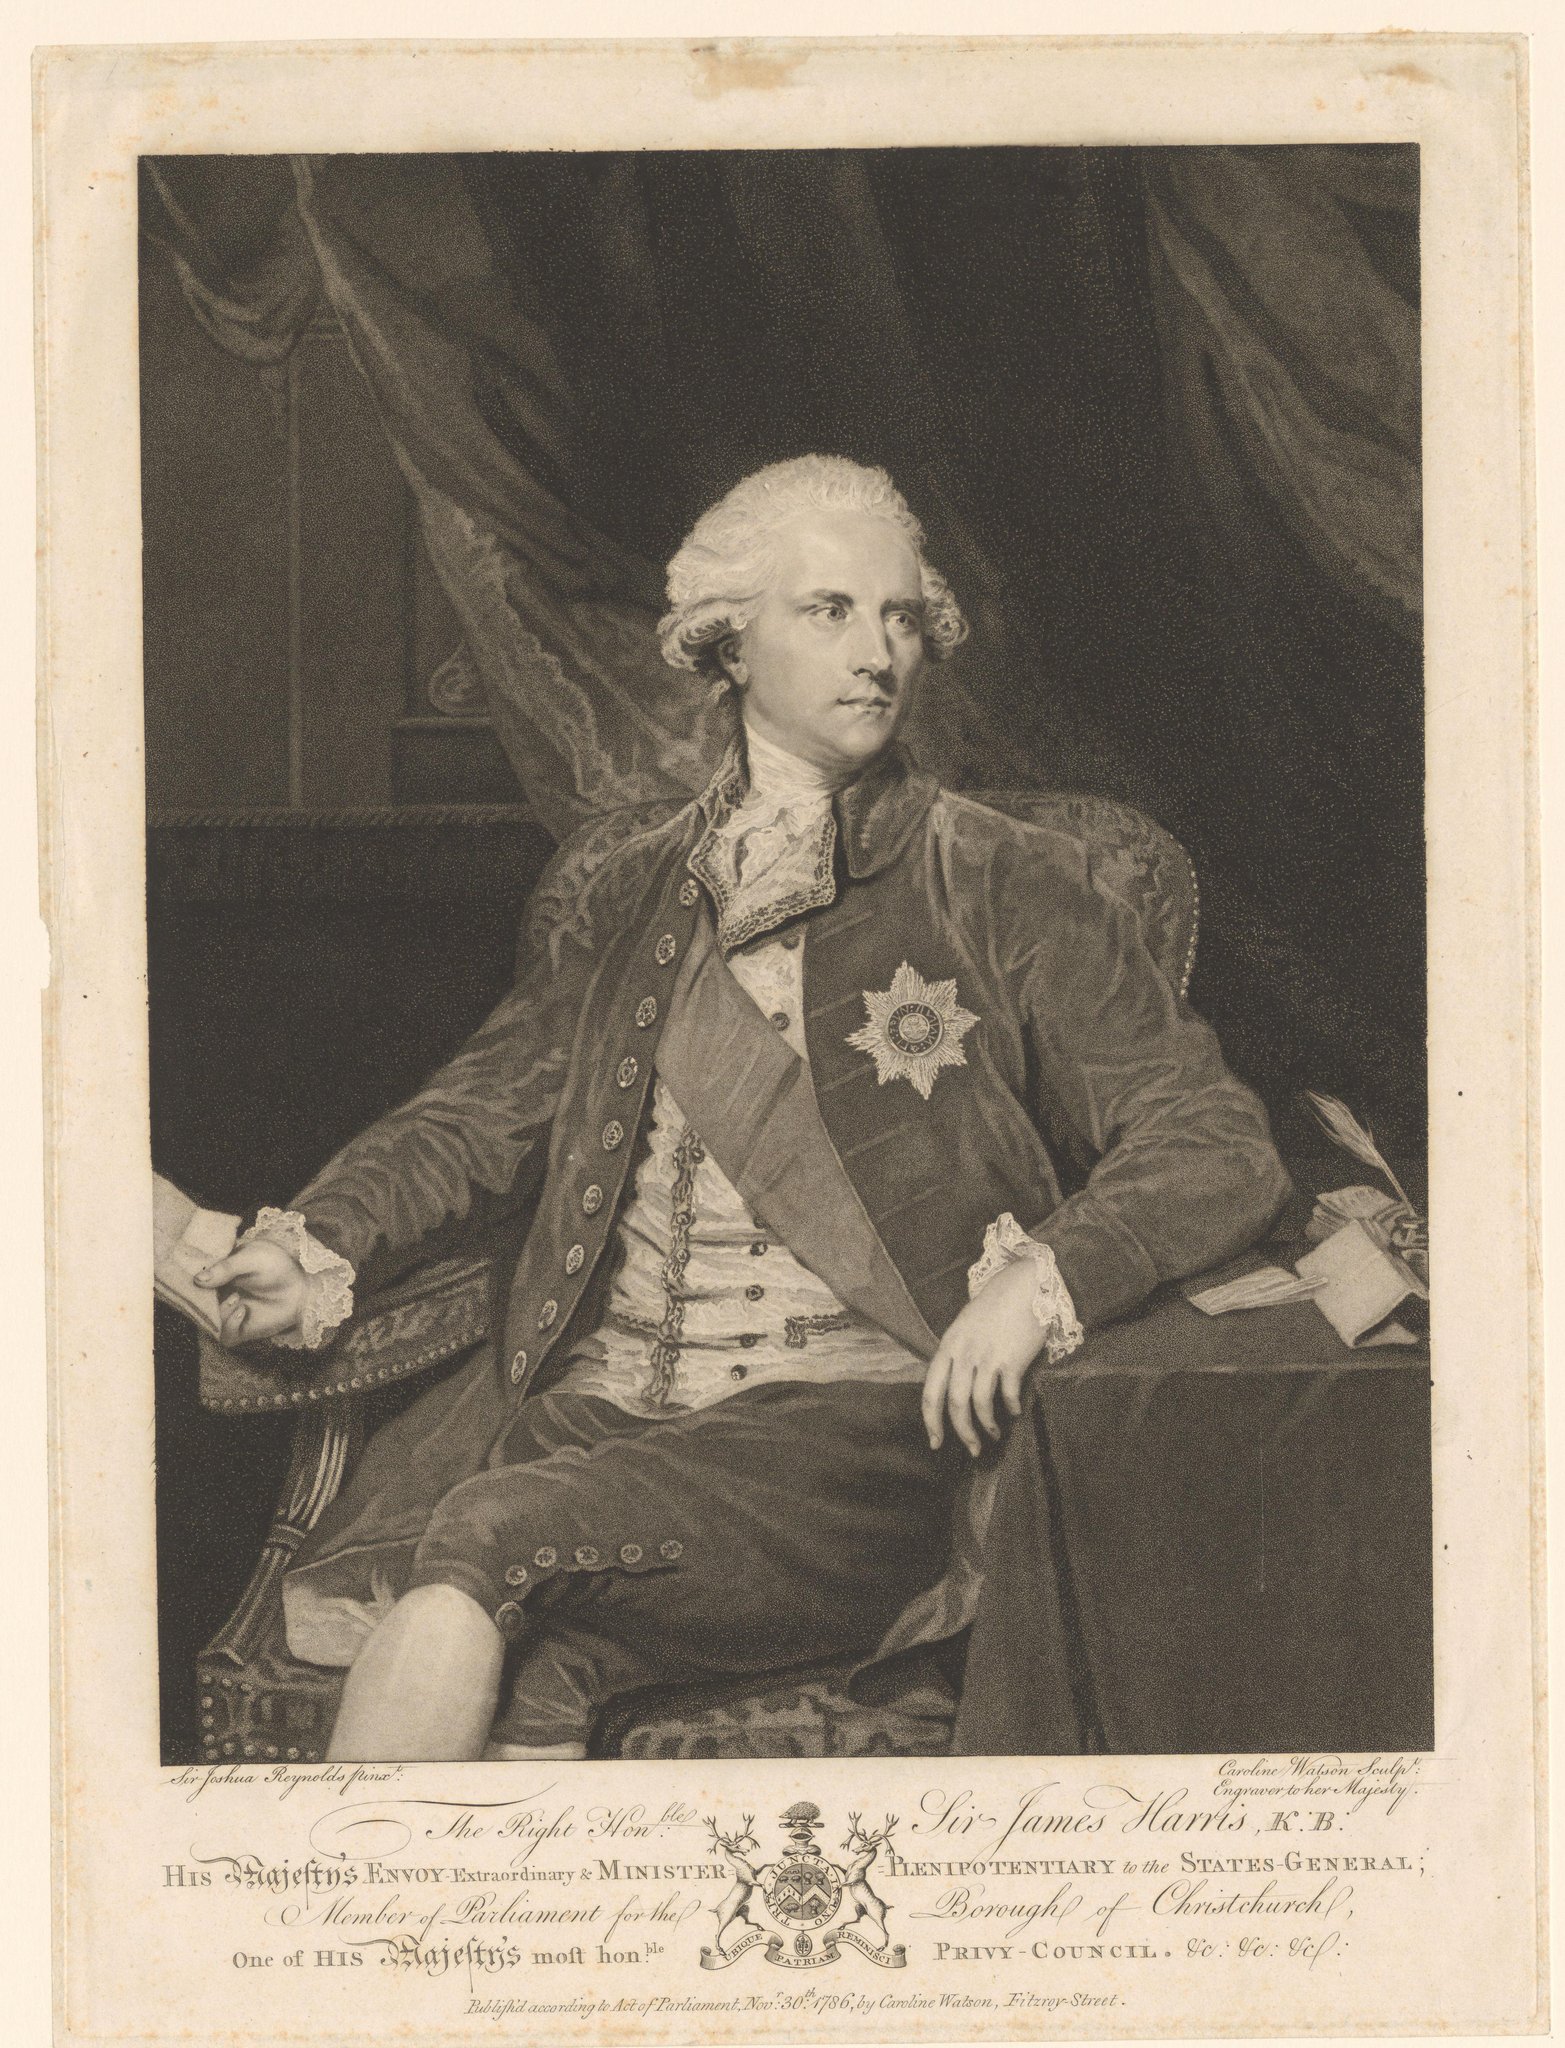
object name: print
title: Portret van James Harris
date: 1786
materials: paper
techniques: etching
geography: london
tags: historical persons, politician, e.g. party leader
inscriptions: collector's mark: Lugt 964